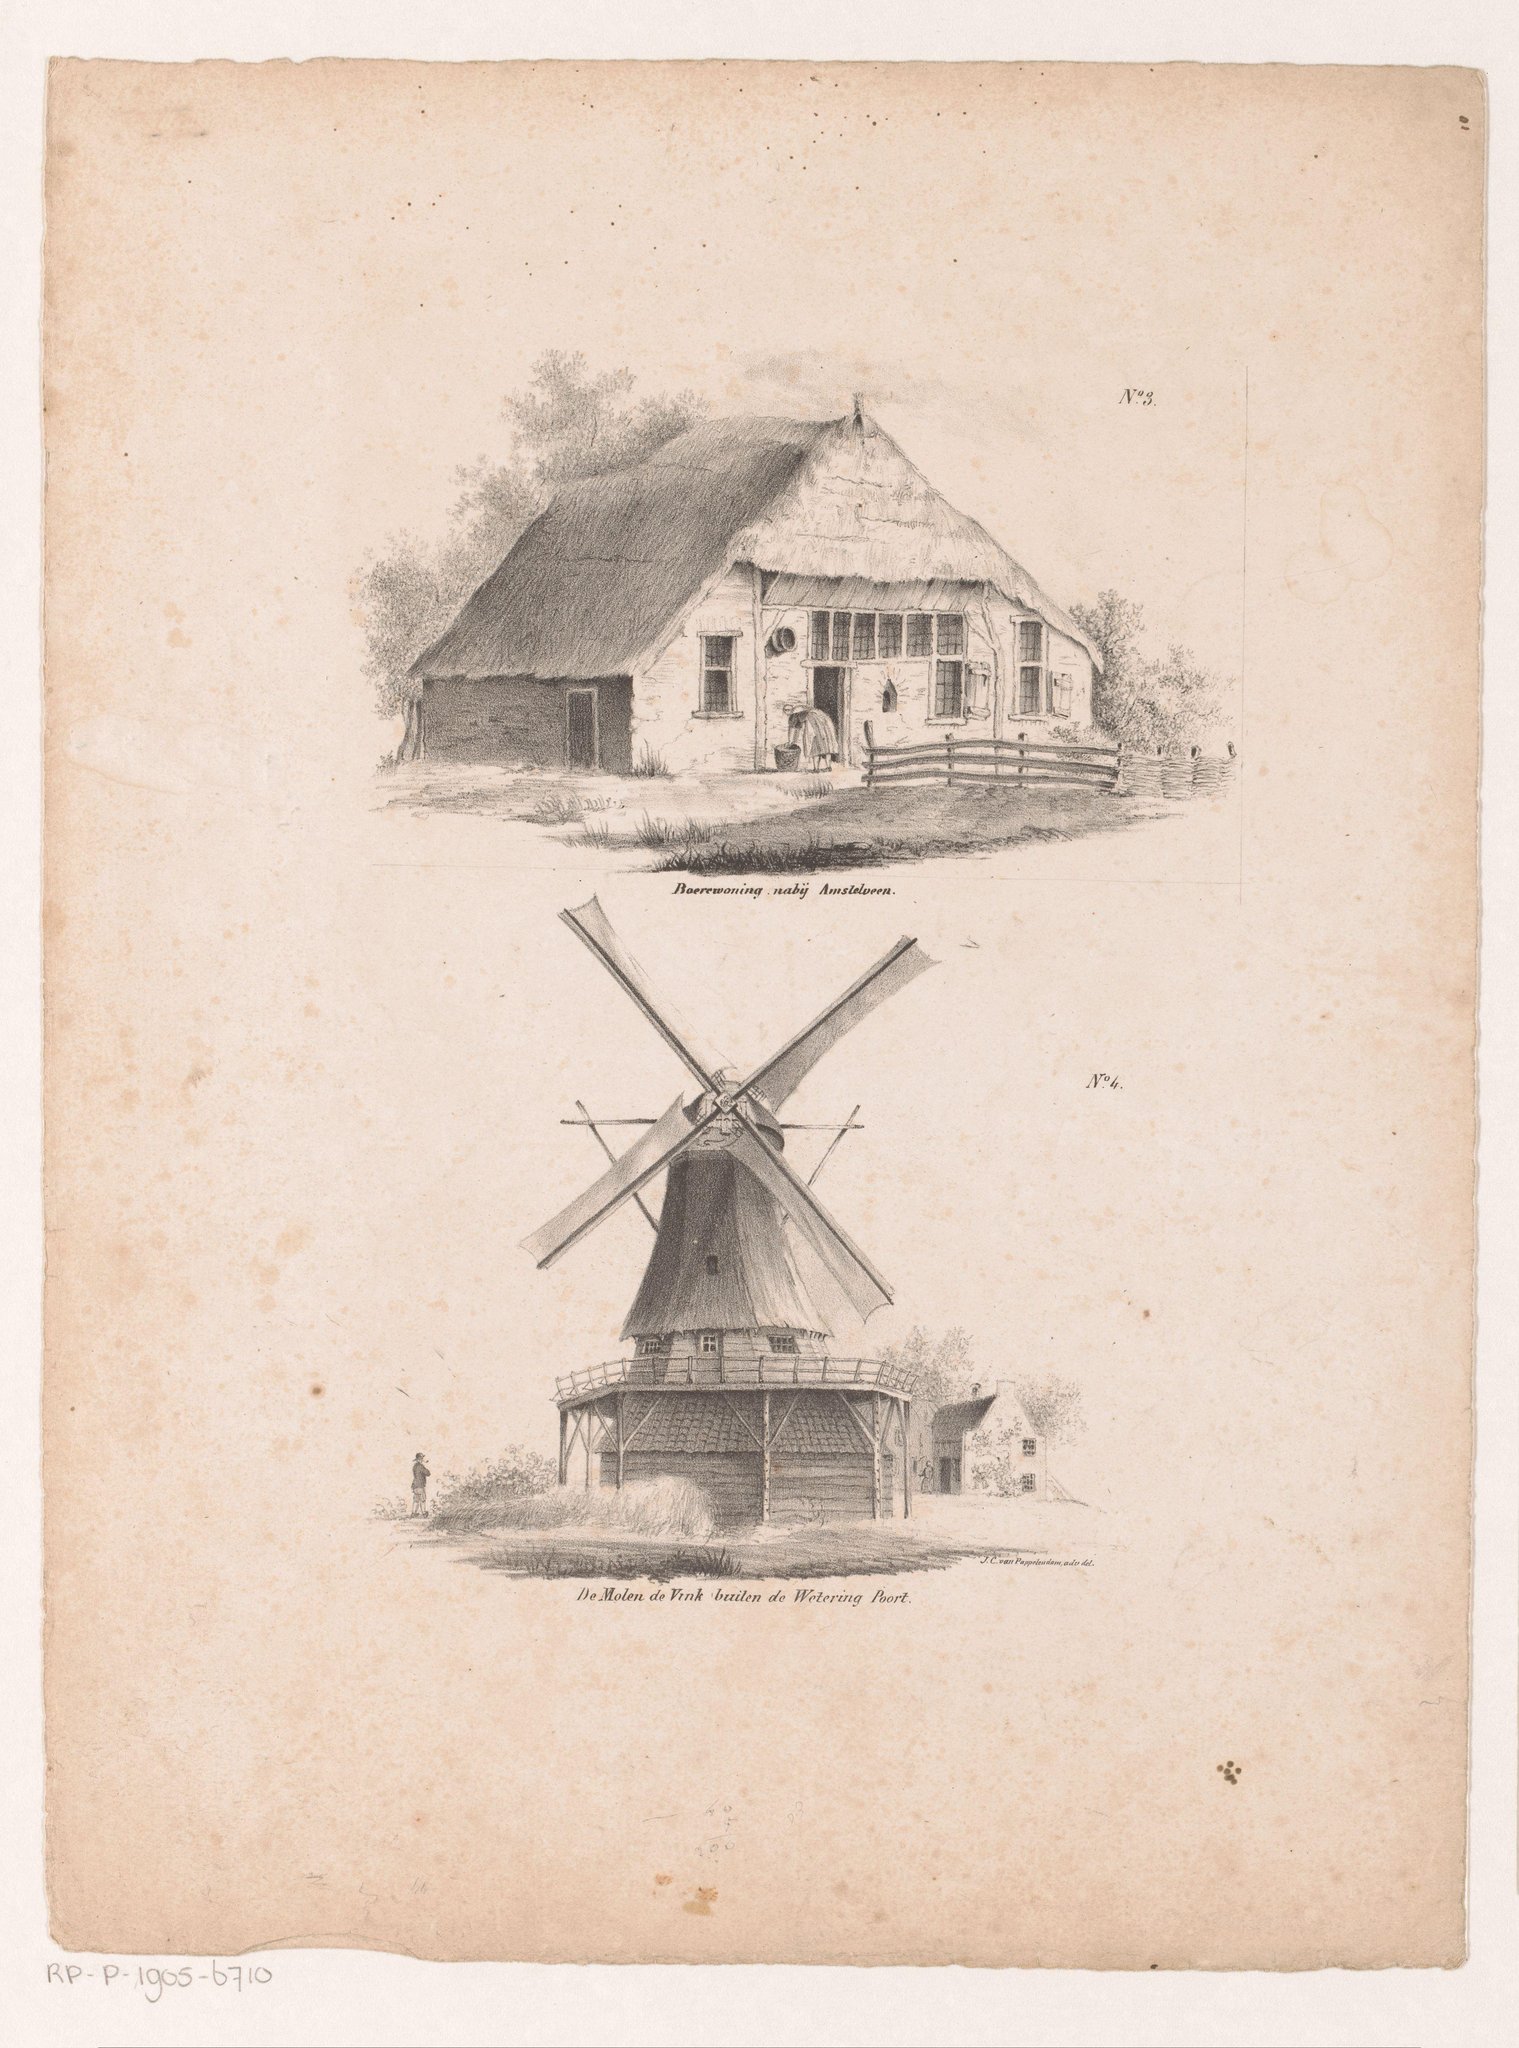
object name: print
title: Gezichten in de omgeving van Amsterdam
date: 1825-1845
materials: paper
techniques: lithograph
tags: windmill in landscape, farm or solitary house in landscape, amsterdam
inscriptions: collector's mark: Lugt 2228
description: Gezichten op een boerenwoning in de buurt van Amstelveen en molen de Vink tussen de Wetering en Weteringsluis.